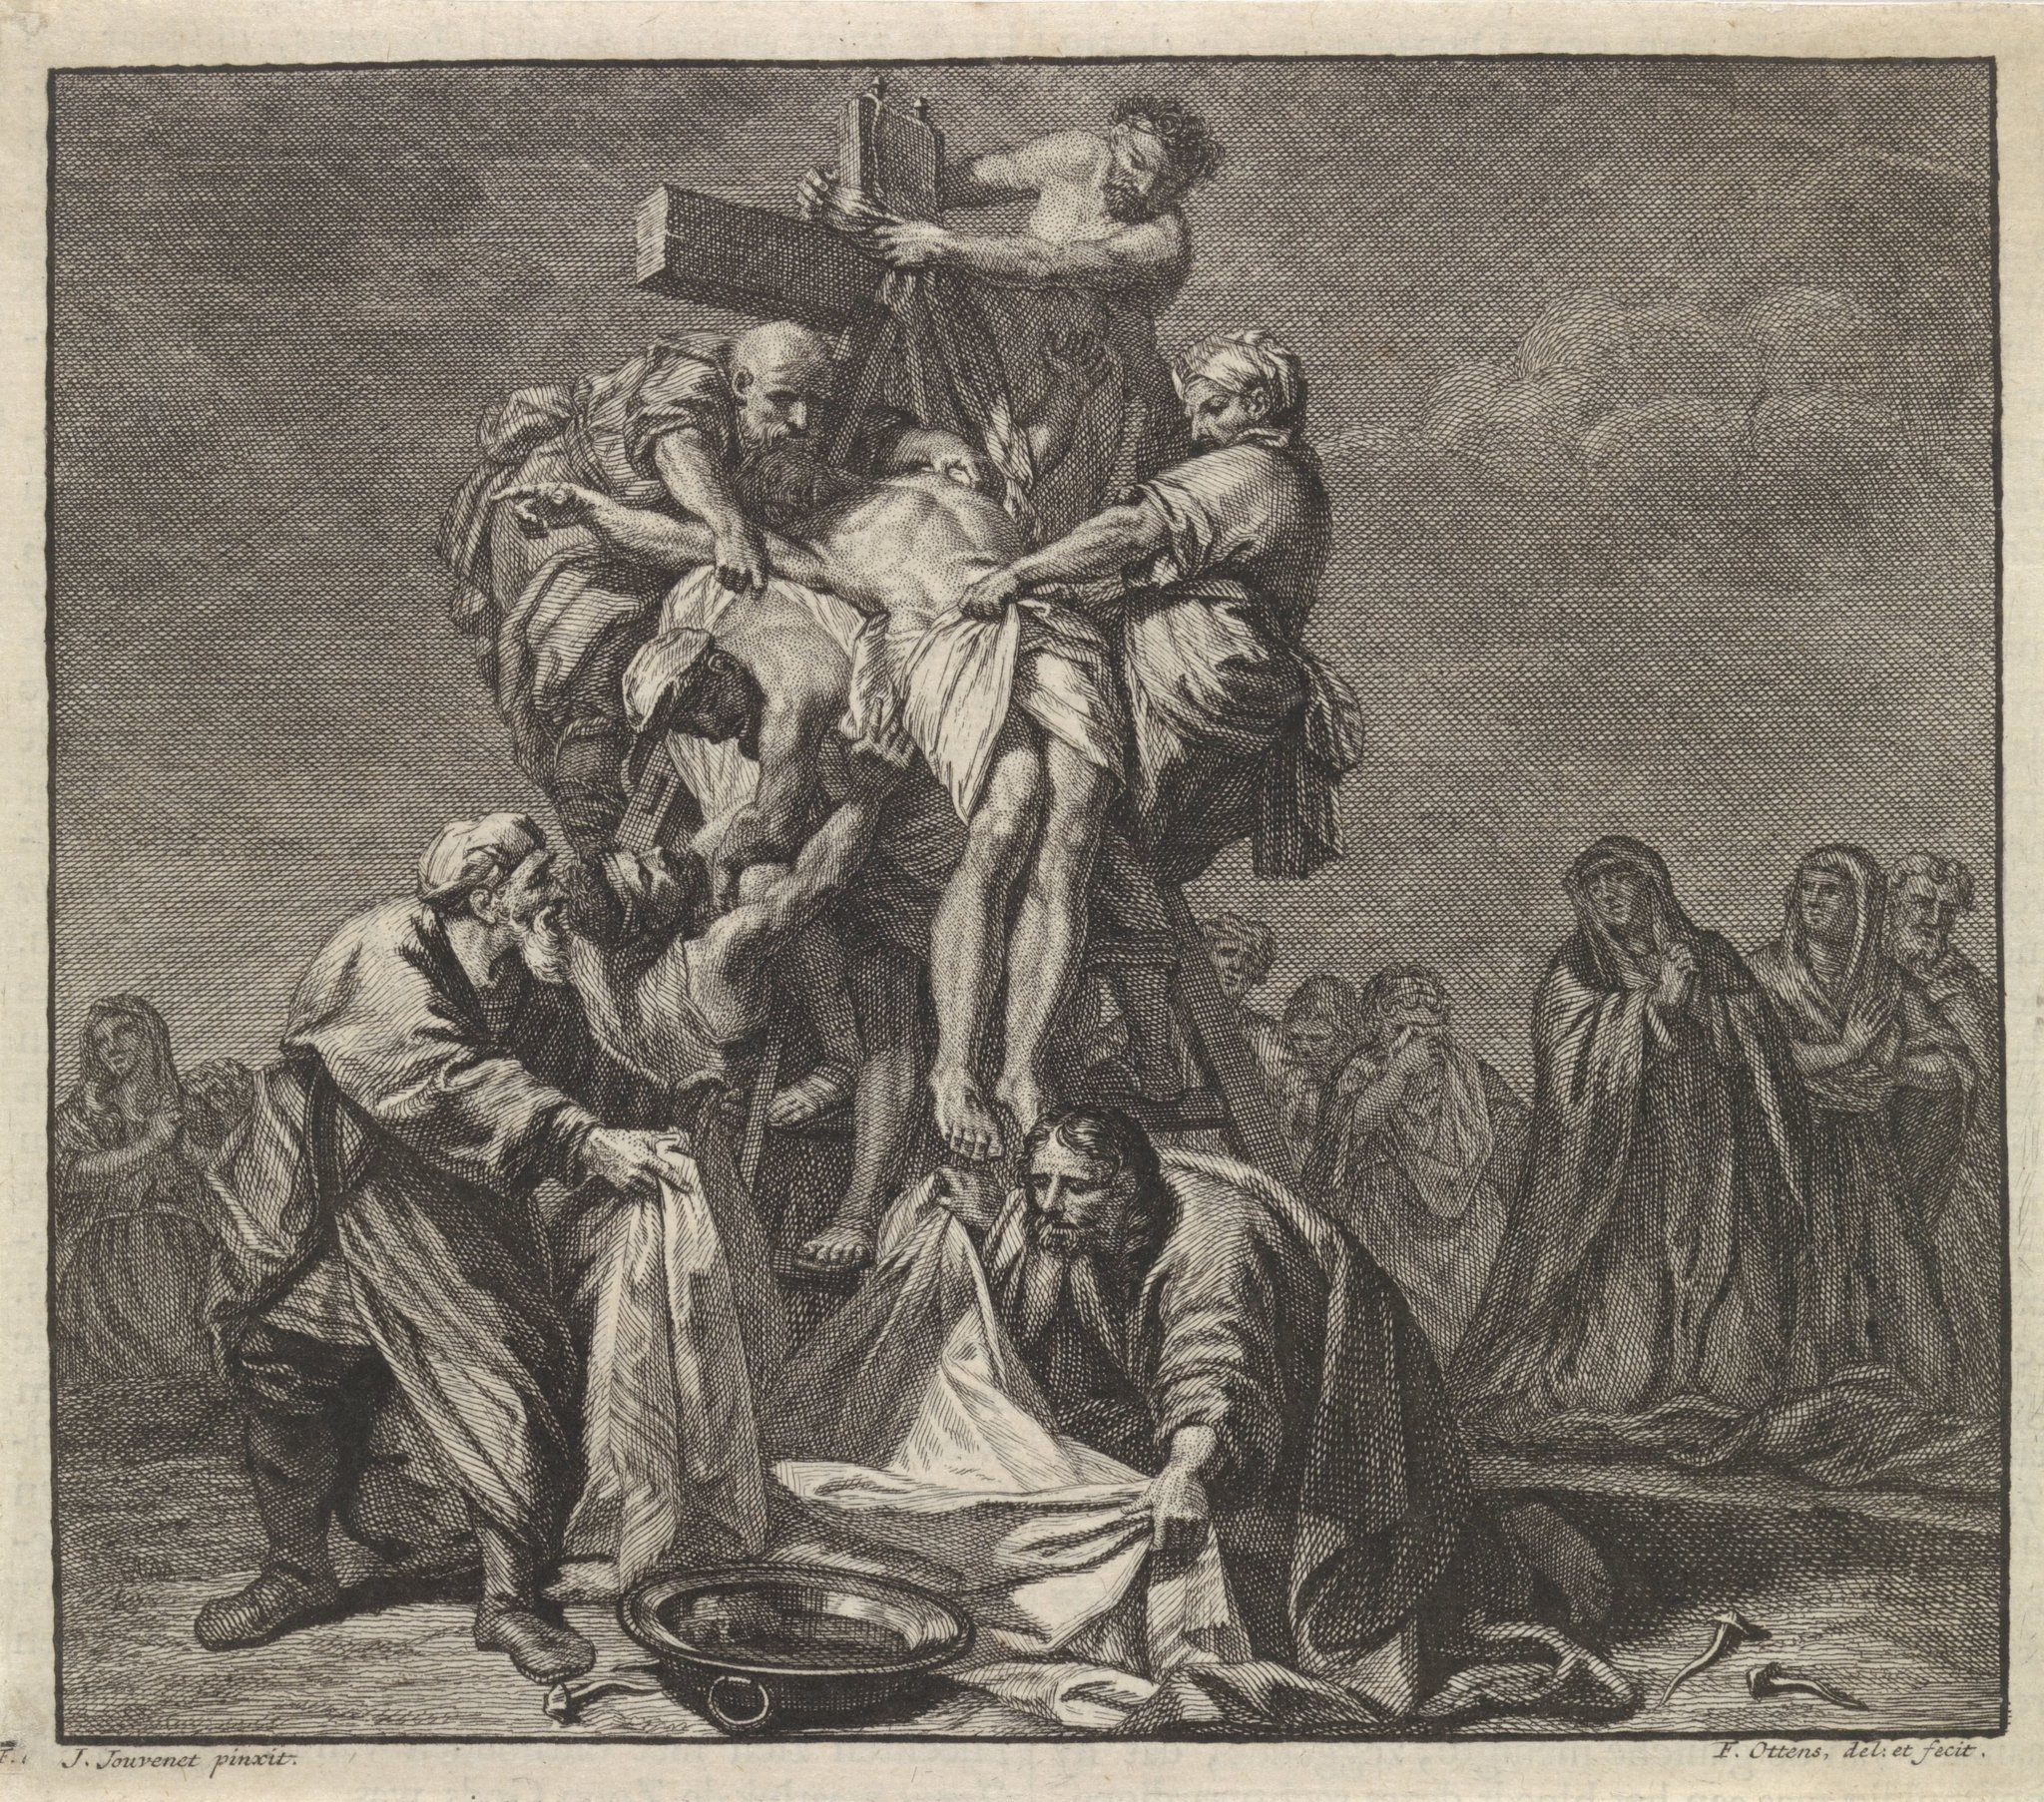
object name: book illustration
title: Kruisafname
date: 1718-1770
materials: paper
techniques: engraving, etching, letterpress printing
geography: amsterdam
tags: descent from the cross: christ is taken down from the cross, usually by nicodemus and joseph of arimathaea who are standing on the ladders (both arms of christ detached)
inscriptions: collector's mark: Lugt 2228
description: Christus wordt van het kruis gehaald door Nikodemus, Jozef en anderen. De lijkwade wordt op de grond uitgelegd. Naast het doek staat een schaal met water om het lichaam te wassen. De vrouwen knielen op een afstand en bidden.